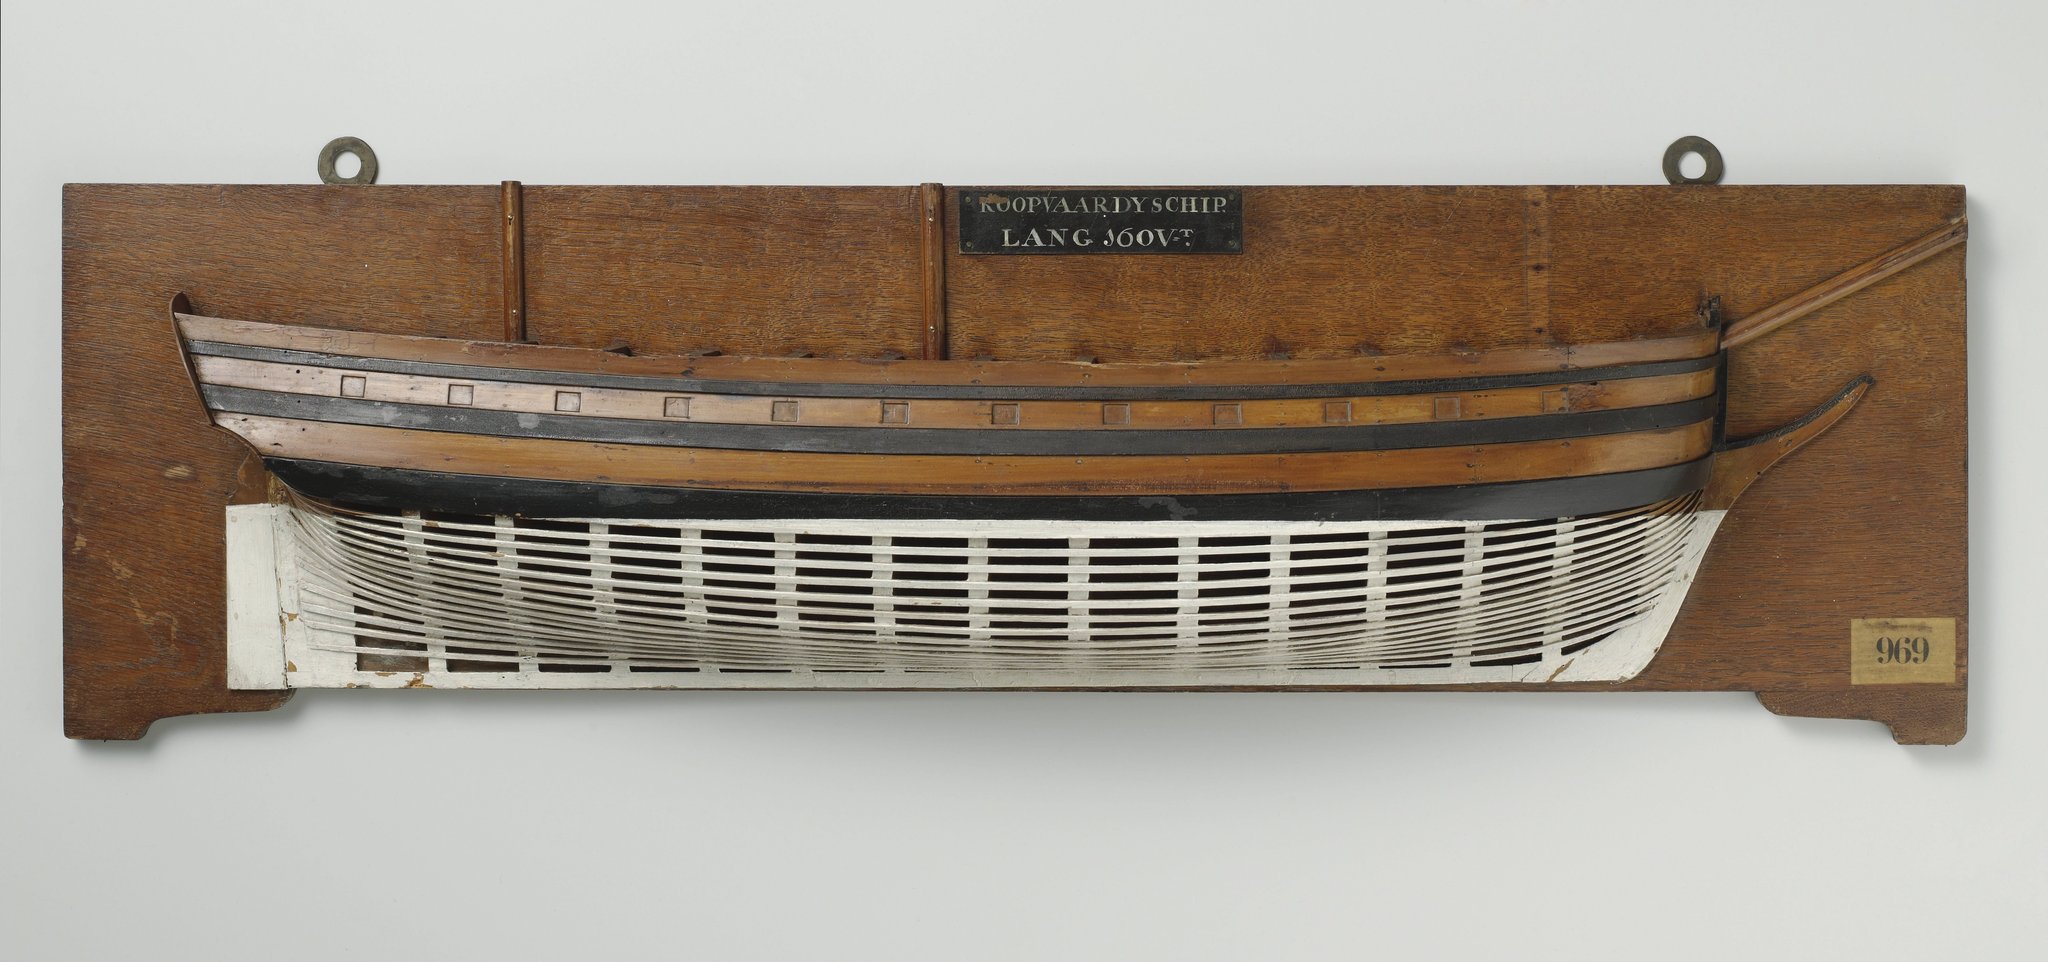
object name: ship model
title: Half Model of a Merchantman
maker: Anonymous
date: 1780-1820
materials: wood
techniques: polychromy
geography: netherlands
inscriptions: inscription, top centre, on a rectangular black label: ‘KOOPVAARDIJSCHIP. / LANG 160 VT.’, label, bottom right: ‘969’ former inventory label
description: Mallenmodel (stuurboord) van een driemaster. De huid boven het barkhout is gesloten en heeft twaalf poorten op één dek. Gewrongen spiegel, hol wulf, hek gesloten, geen zijgalerij; recht roer met vierkante roerkoning. Zeeg naar voren en naar achter oplopend, twee barkhouten en één reehout. Gepiekt rondspant. Schaal ca. 1:64 (afgeleid).